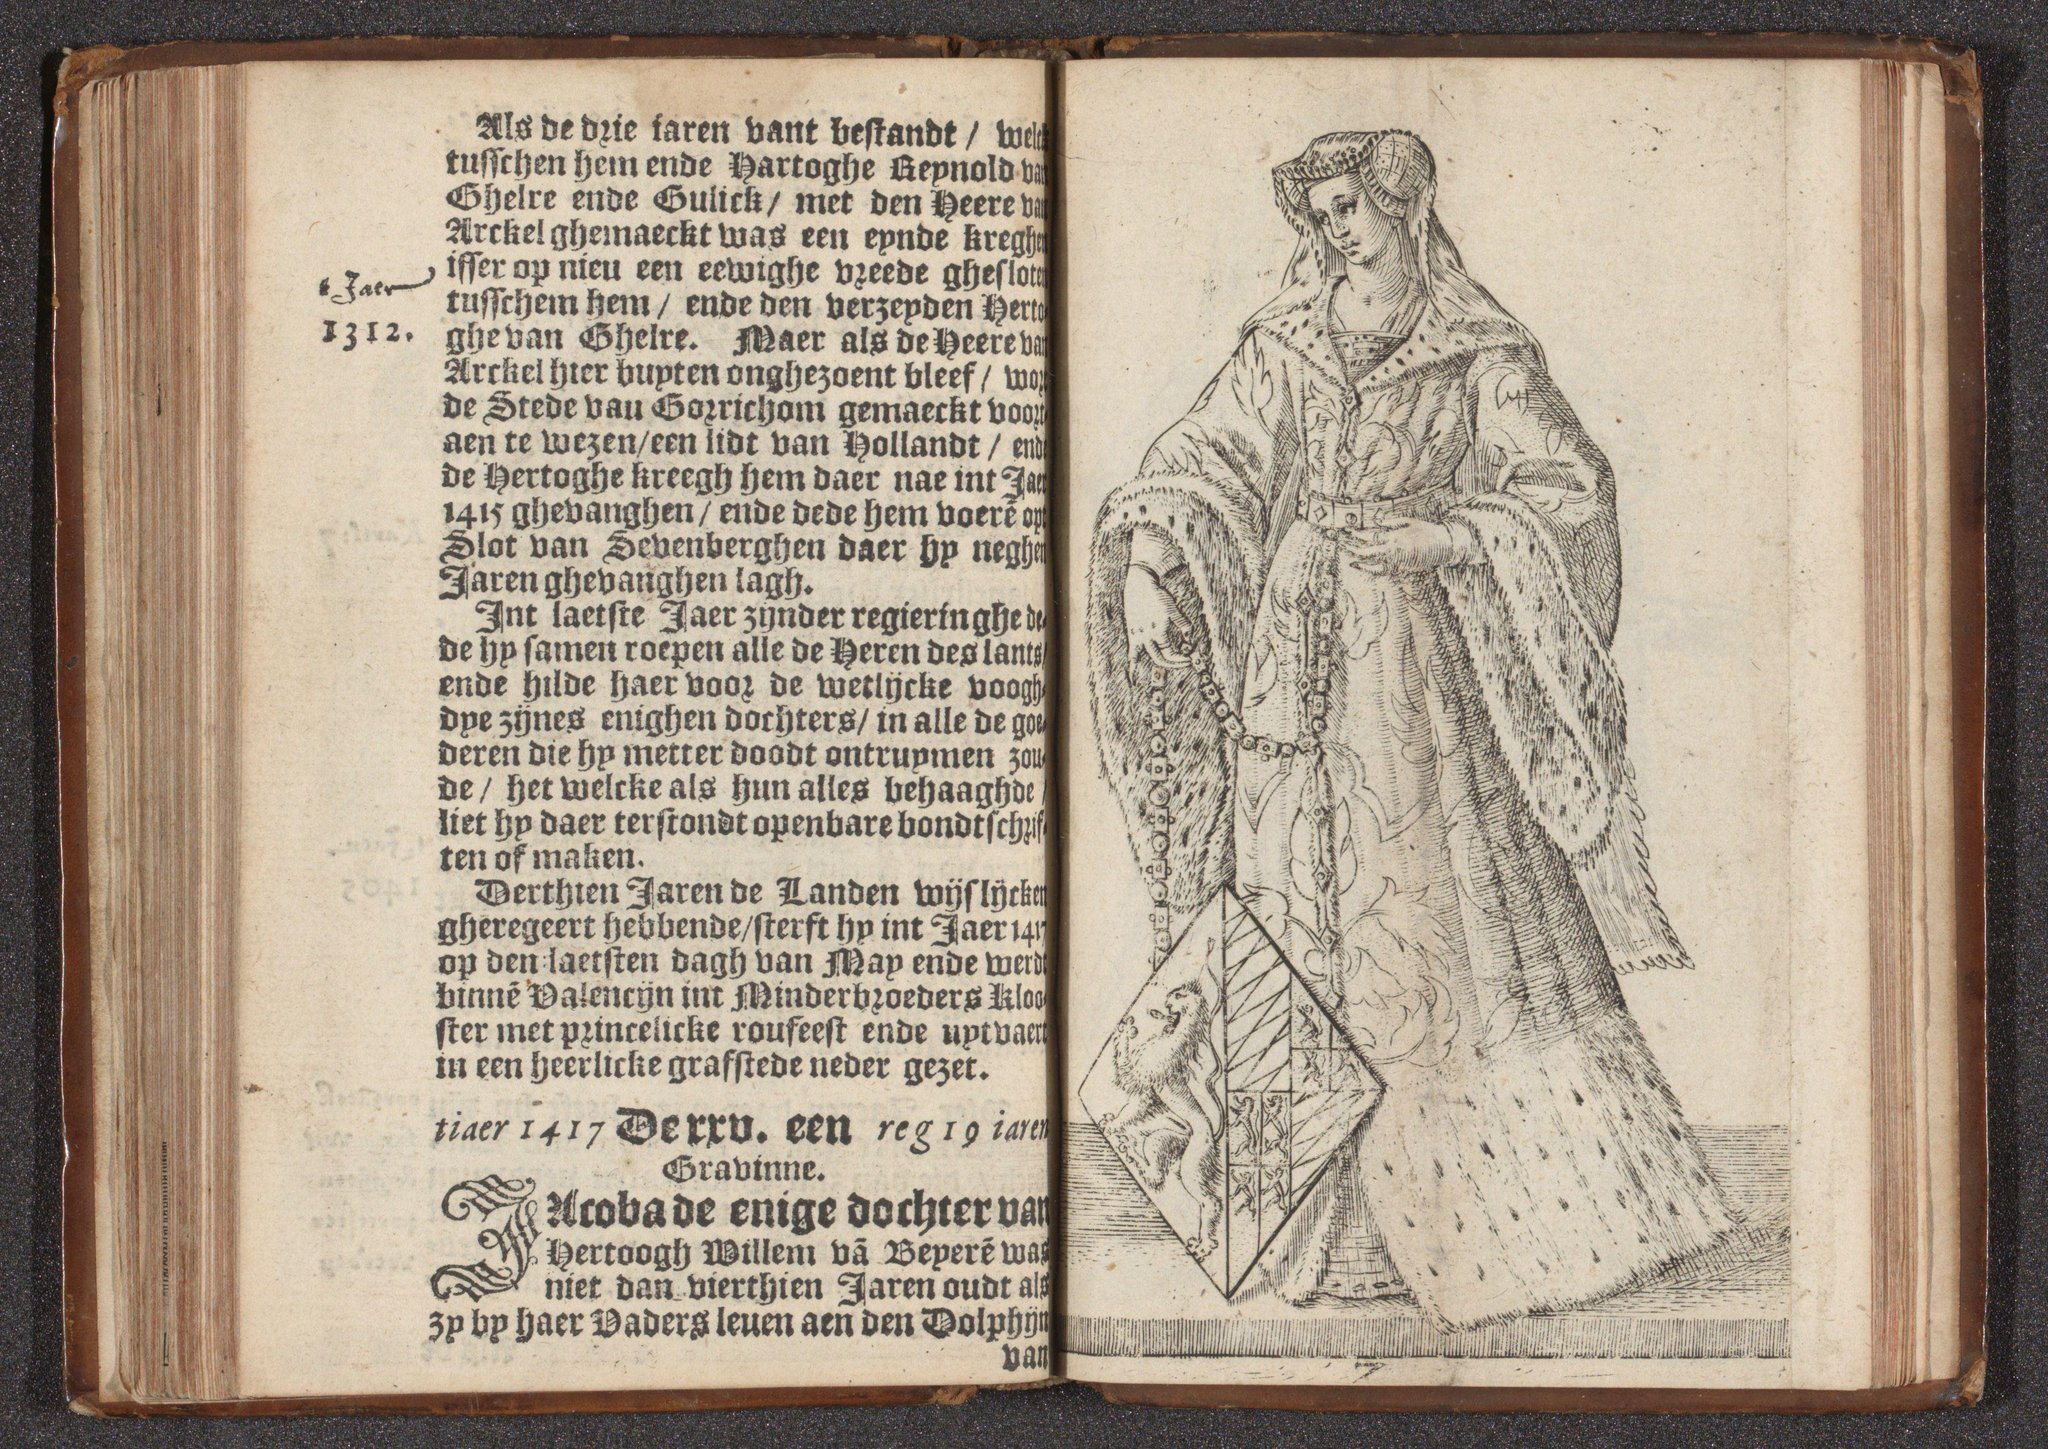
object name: album leaf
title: Gravin Jacoba van Beieren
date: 1586-1587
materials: paper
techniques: engraving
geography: haarlem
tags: jacoba of bavaria (countess of hainaut), historical persons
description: Gravin Jacoba van Beieren, ten voeten uit, en met wapenschild. Onderaan genummerd 7. De prent maakt deel uit van een boek met beschrijvingen en voorstellingen van de graven van Holland, Zeeland en Friesland.